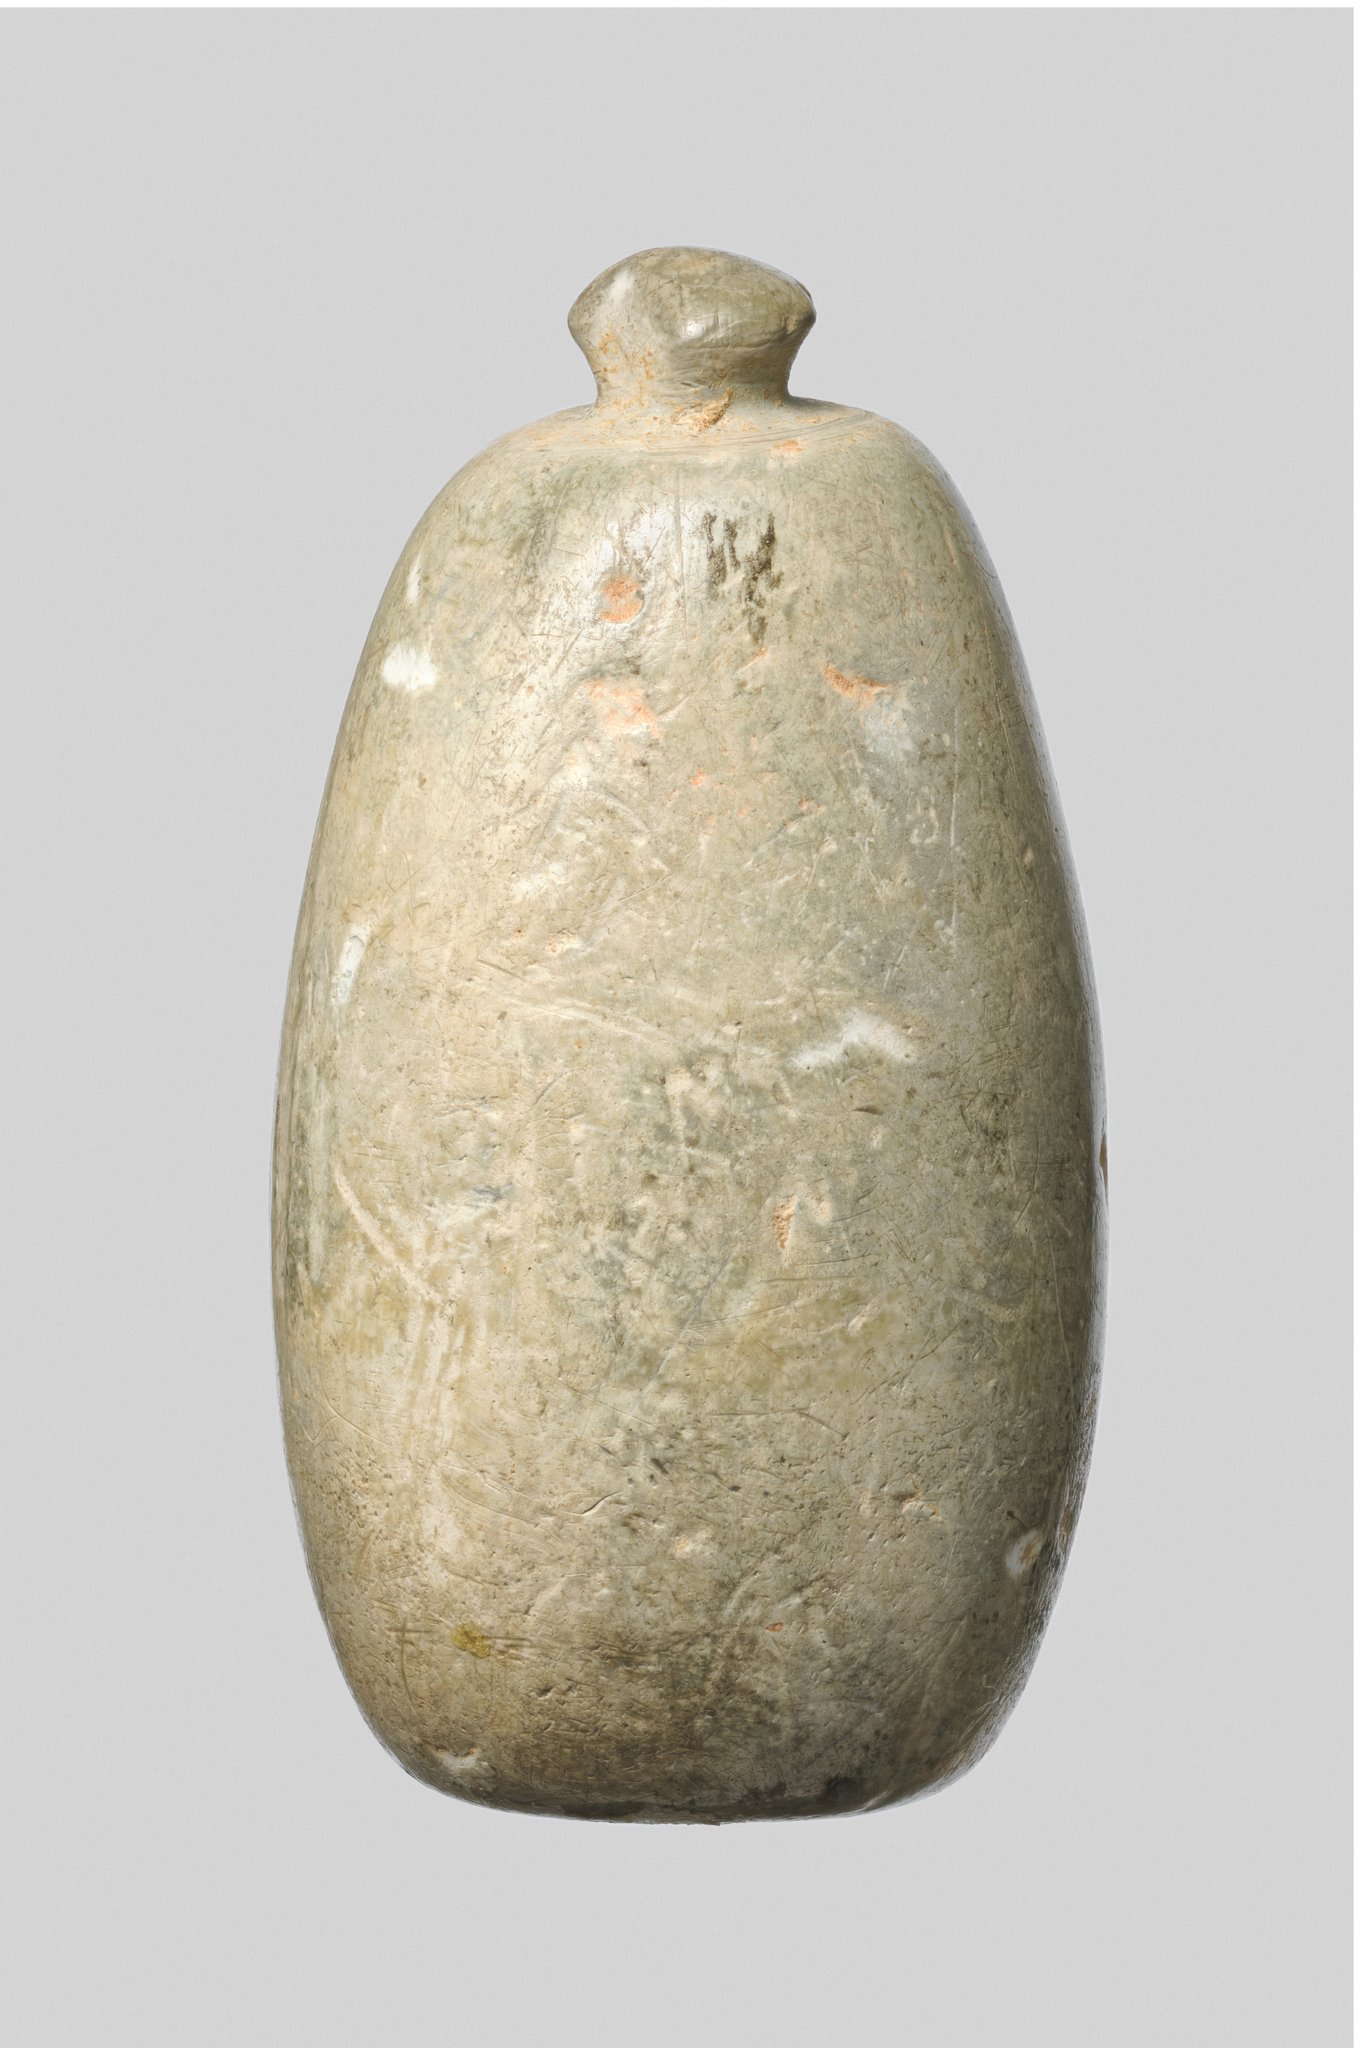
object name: pendant or weight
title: Serpentinite pendant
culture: cypriot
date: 3900-2500 BCE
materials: stone